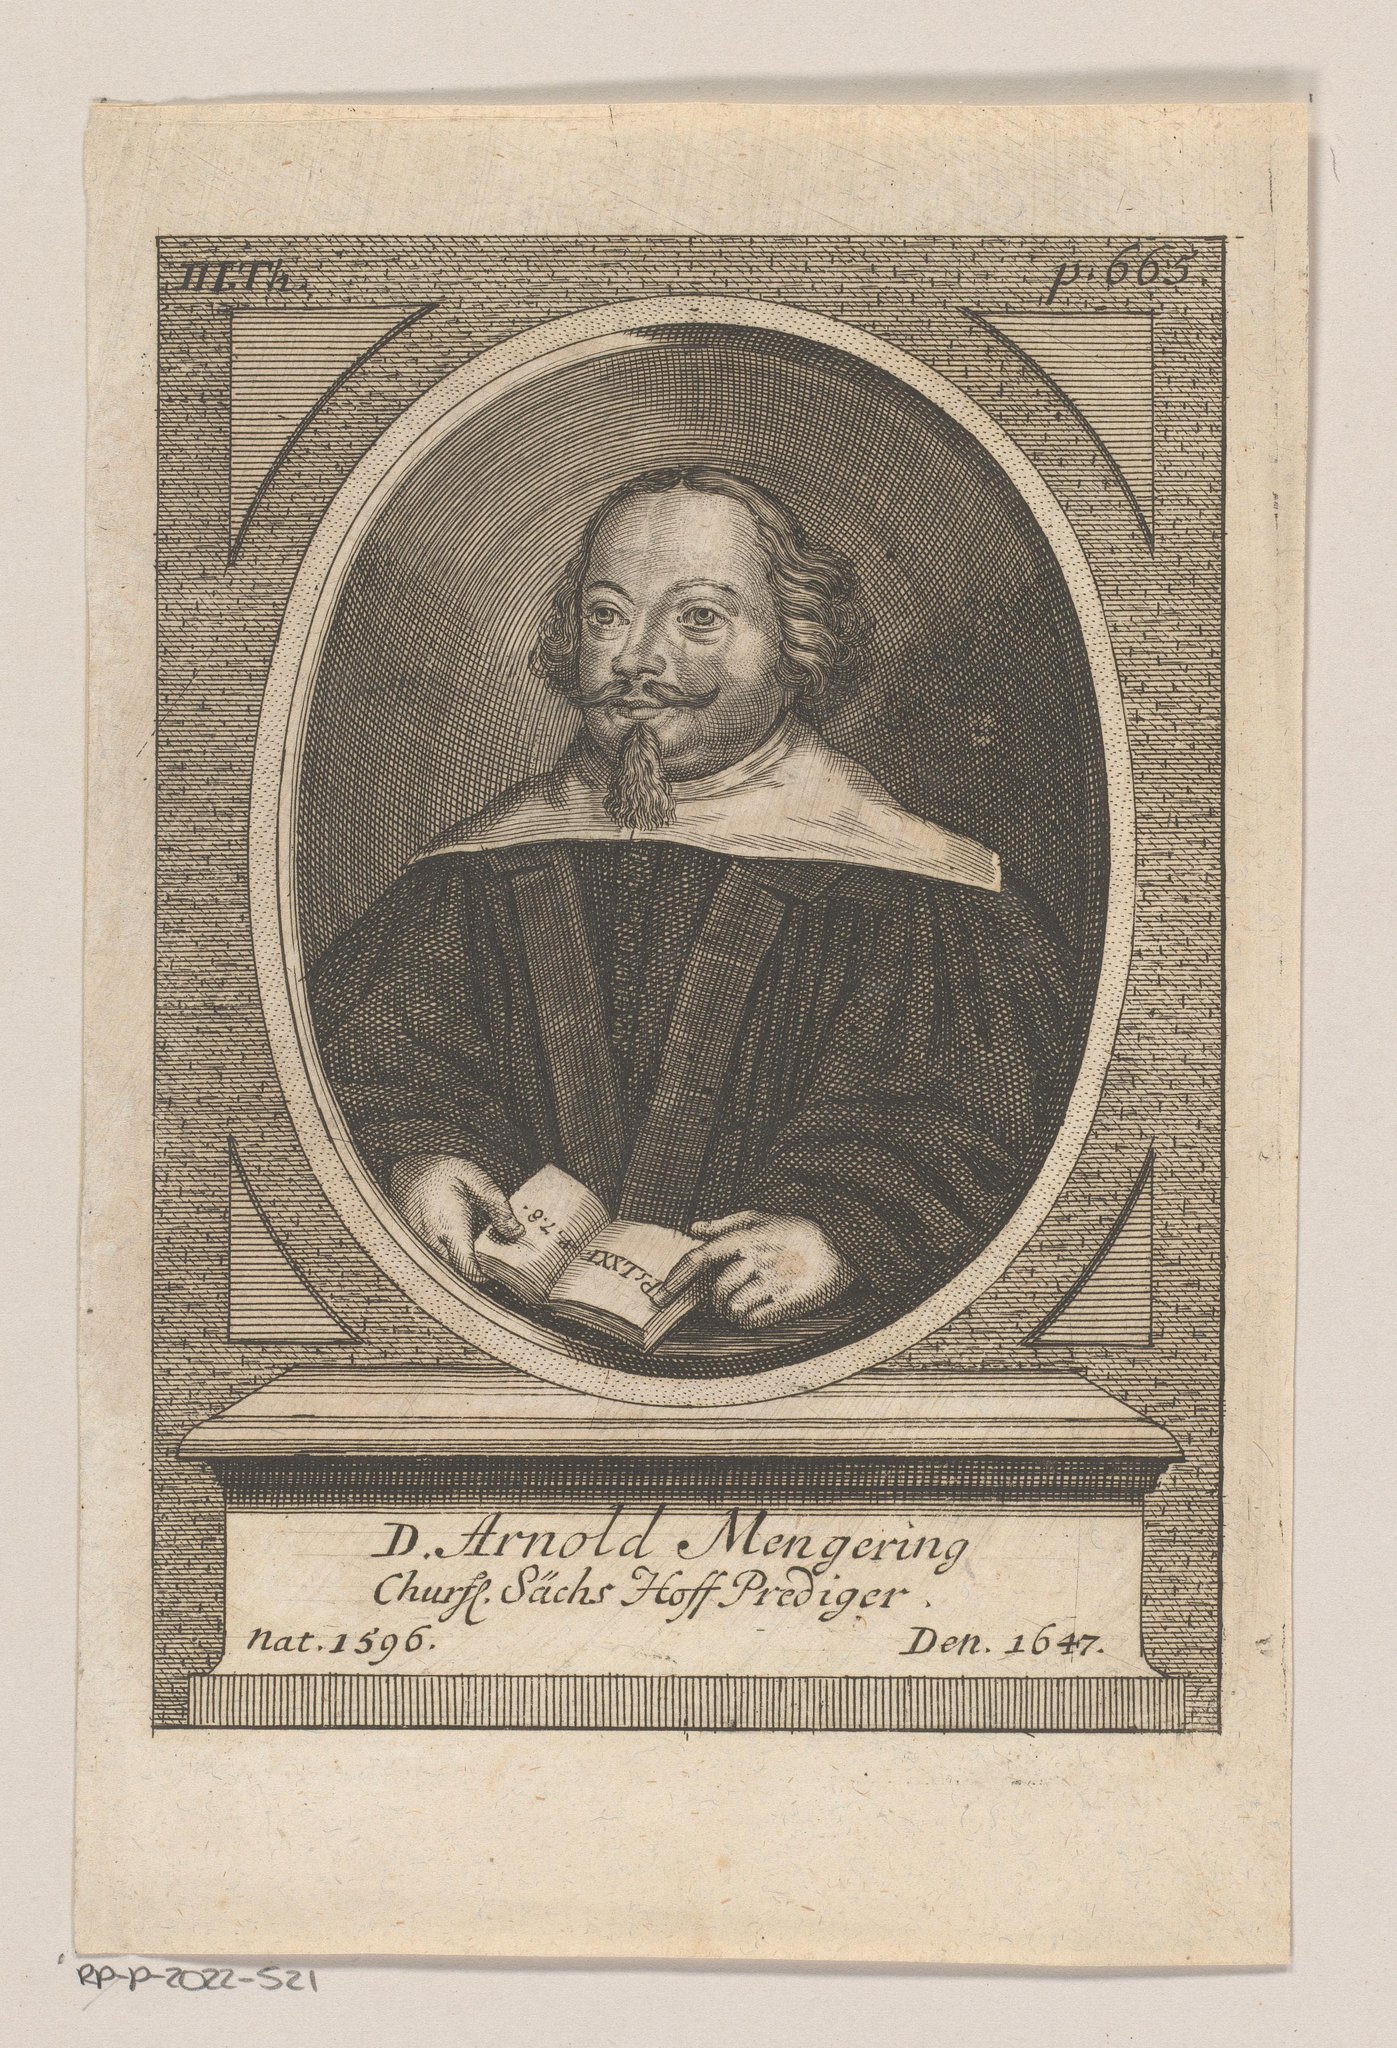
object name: print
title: Portret van Arnold Mengering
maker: Anonymous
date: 1730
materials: paper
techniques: engraving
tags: historical persons, book, index finger forwards, pointing, indicating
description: Prent waarschijnlijk uit: Gleich, Johann Andreas. Annales Ecclesiastici, Oder Gründliche Nachrichten der Reformations-Historie, Chur-Sächß. Albertinischer Linie (...). Dresden en Leipzig: Raphael Christan Sauereßi, 1730, p. 665.